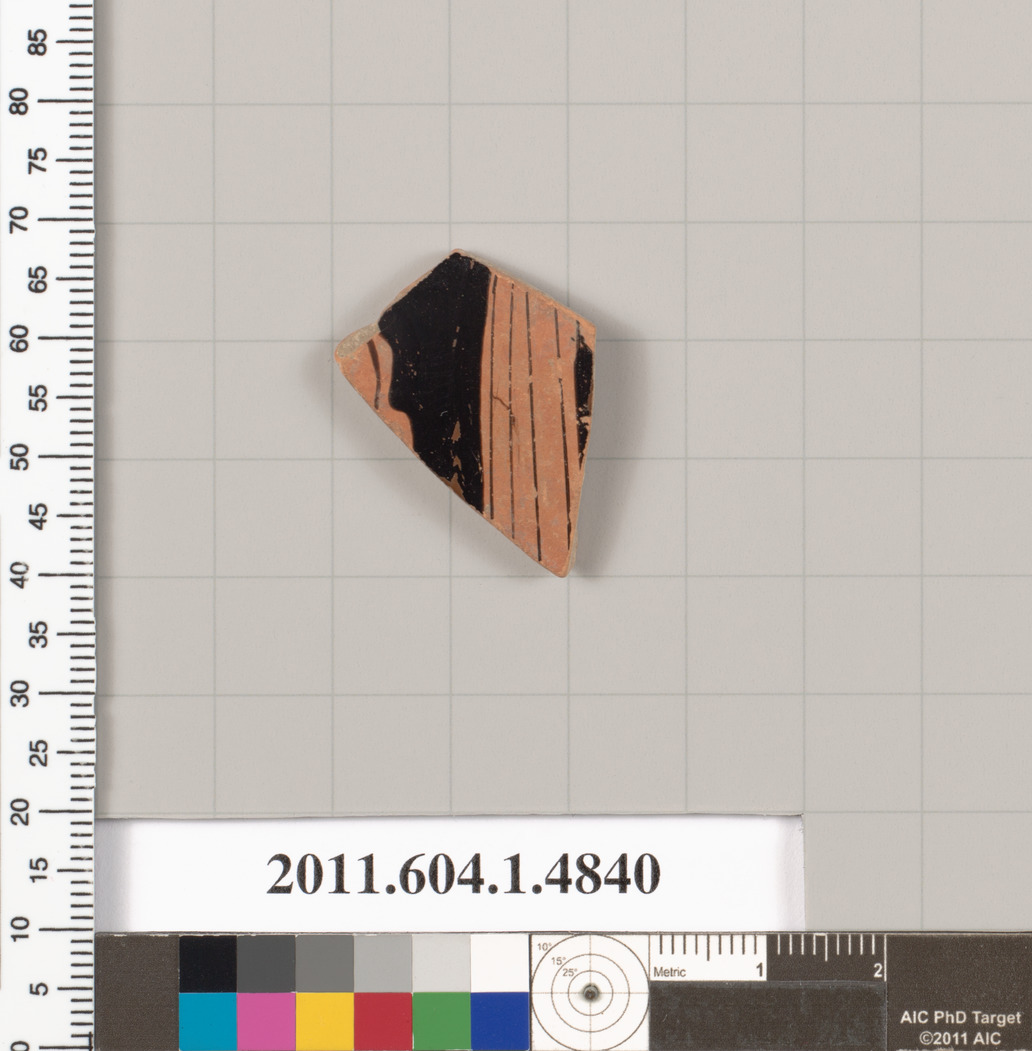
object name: kylix fragment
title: Terracotta fragment of a kylix (drinking cup)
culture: greek, attic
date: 467-435 BCE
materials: terracotta